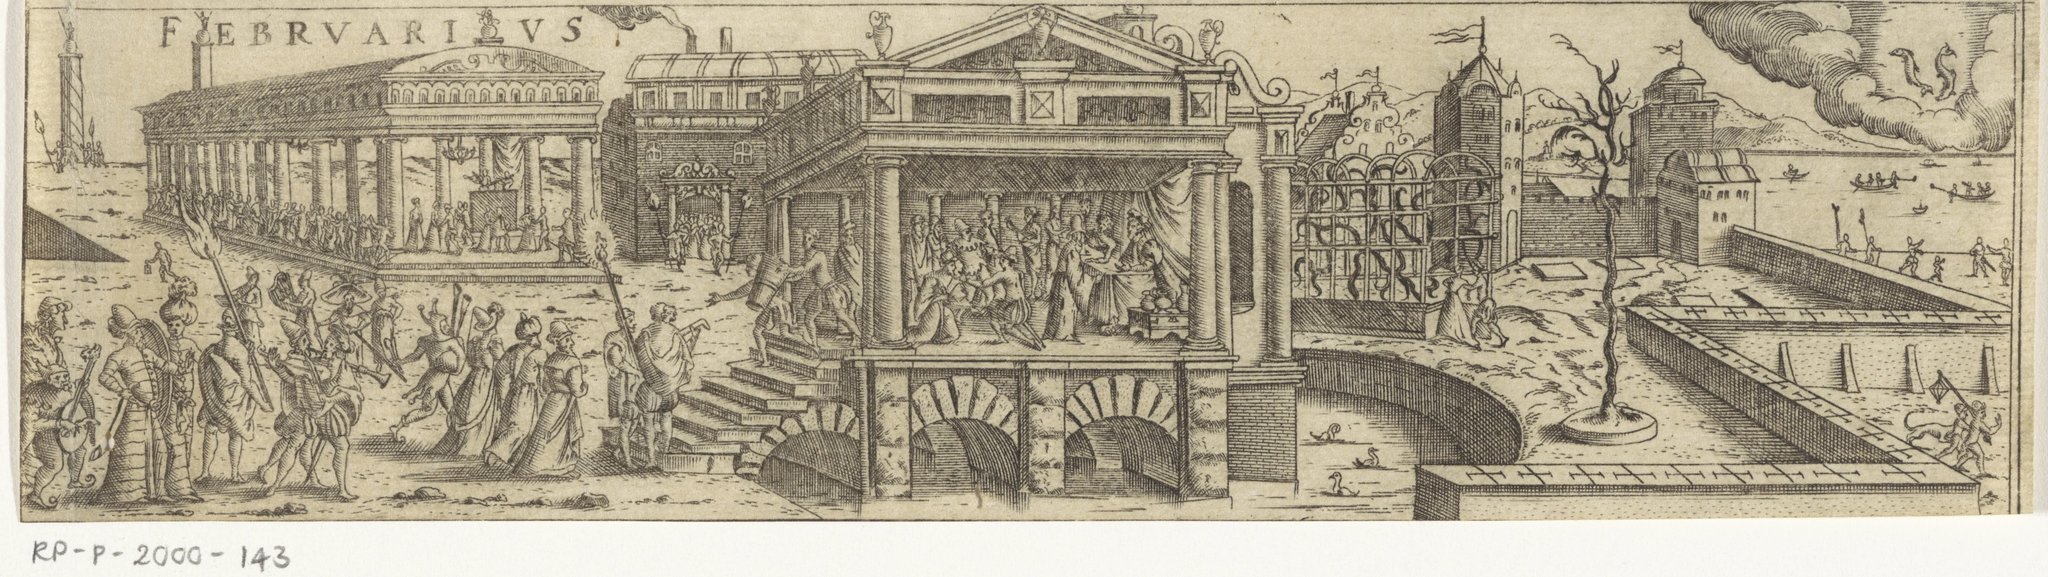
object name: print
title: Februari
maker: Anonymous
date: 1554-1641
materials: paper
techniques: etching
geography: netherlands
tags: february and its 'labours' (+ with zodiacal signs)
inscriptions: collector's mark: Lugt 2760, collector's mark: Lugt 2228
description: Bezigheden in de maand februari. Vooraan een carnavalsoptocht en gemaskerd bal. Linksachter een toneelspel in een gebouw met zuilen. In de lucht het dierenriemteken Vissen.